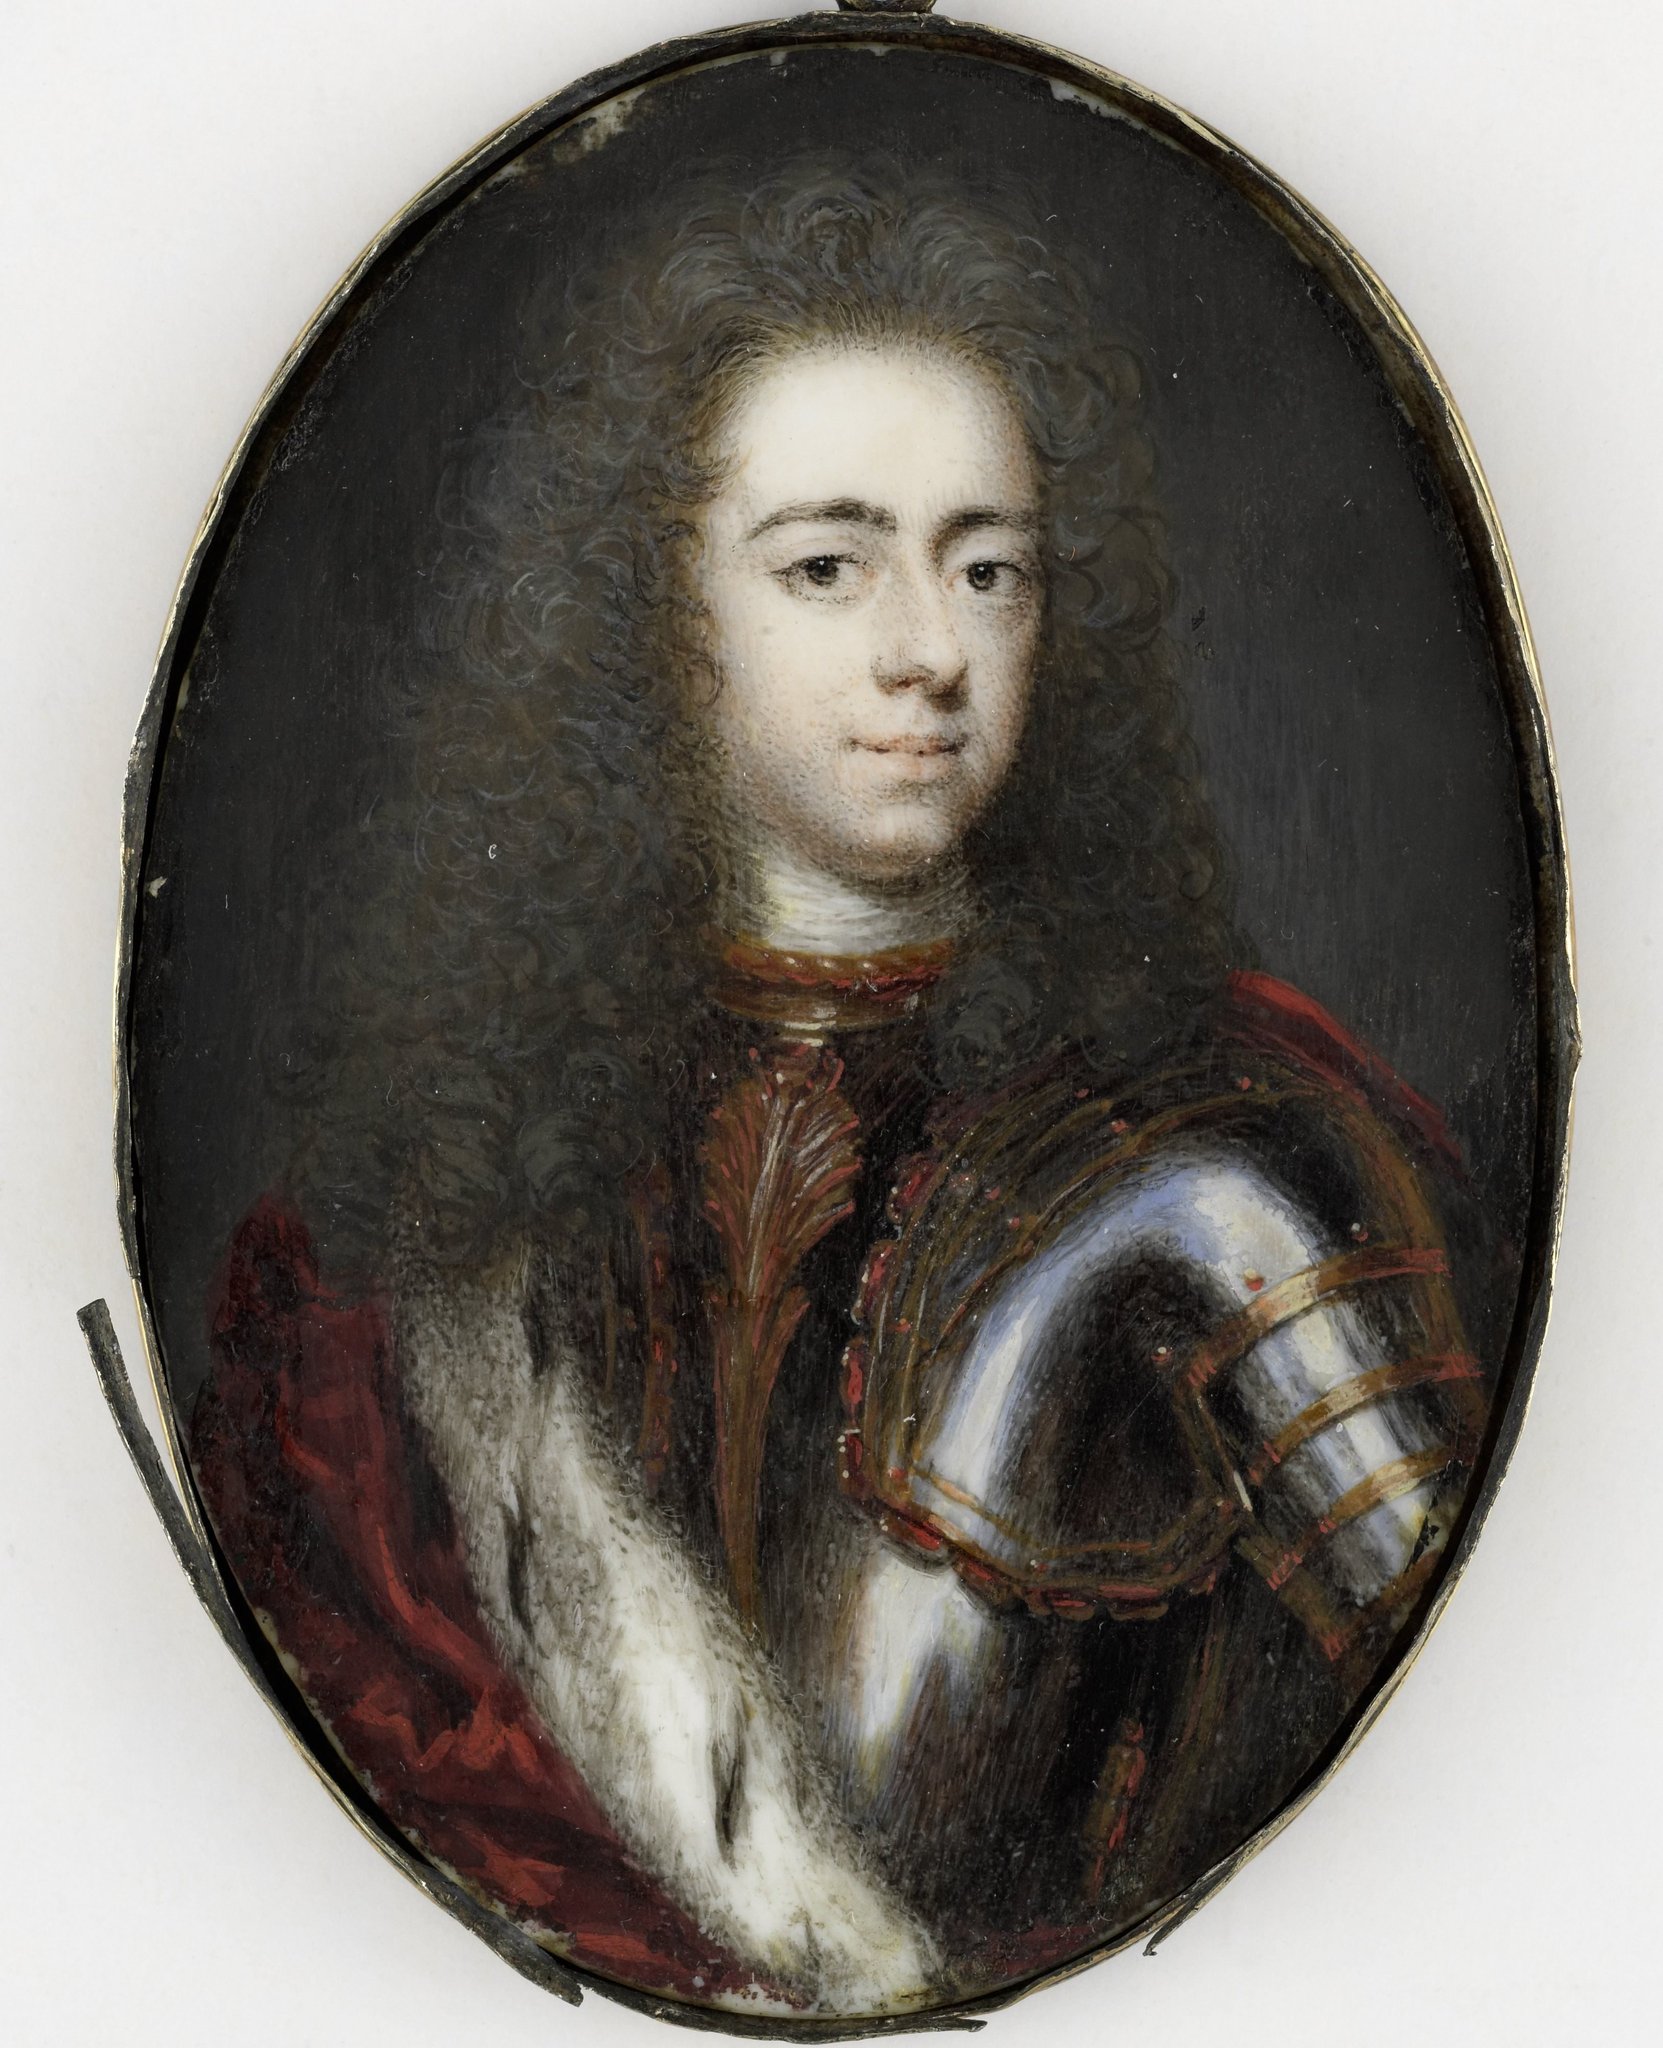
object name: painting, miniature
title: Johan Willem Friso (1687-1711), prins van Oranje-Nassau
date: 1710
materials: ivory, oil, silver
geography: netherlands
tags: johan willem friso (prins van oranje-nassau), historical persons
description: Jacob Christoph Leblon (1667 - 1741). Johan Willem Friso (1687 - 1711), Prince of Orange-Nassau. Ivory, c. 1710.